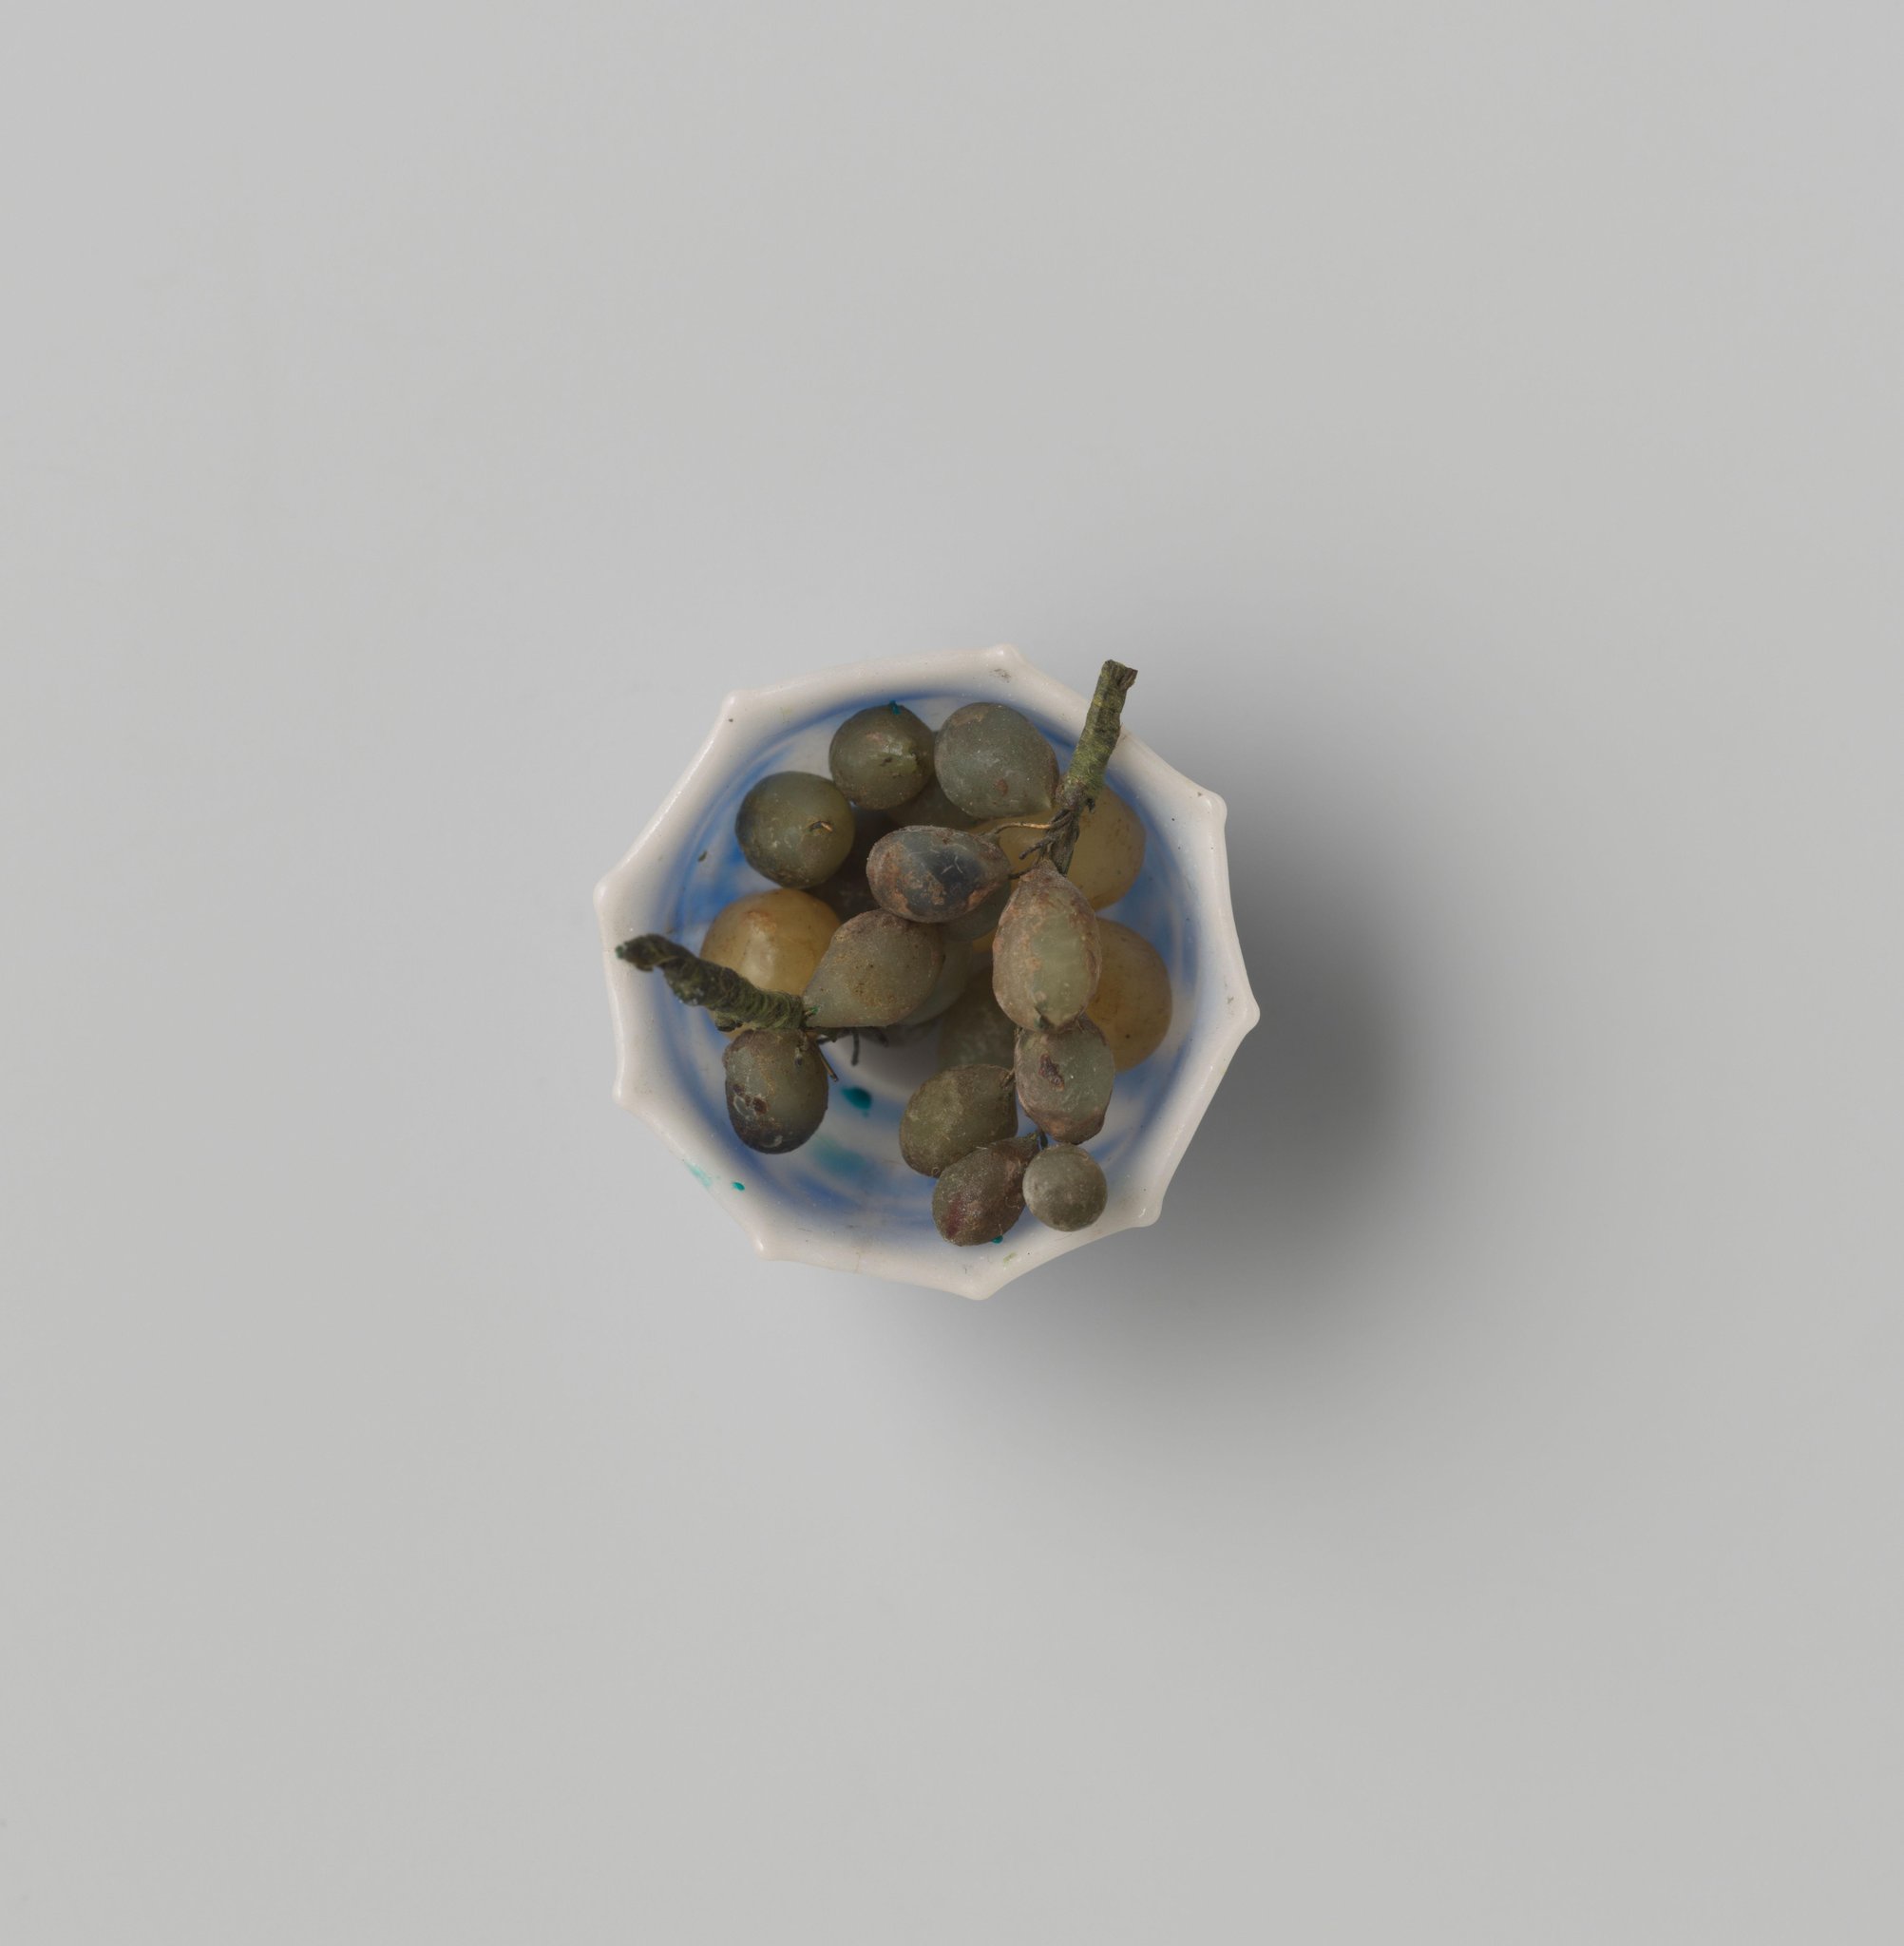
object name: miniature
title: Kom van melkglas met blauwe emailverf beschildering, imitatie Chinees porselein; decoratie van bloemen in drie vakken.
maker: Anonymous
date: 1675-1710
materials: glass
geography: amsterdam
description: Kom van melkglas met blauwe emailverf beschildering, imitatie Chinees blauw porselein; met decoratie van bloemen in drie vakken. De in punten geknepen mondrand imiteert waarschijnlijk een veelhoekige kom.